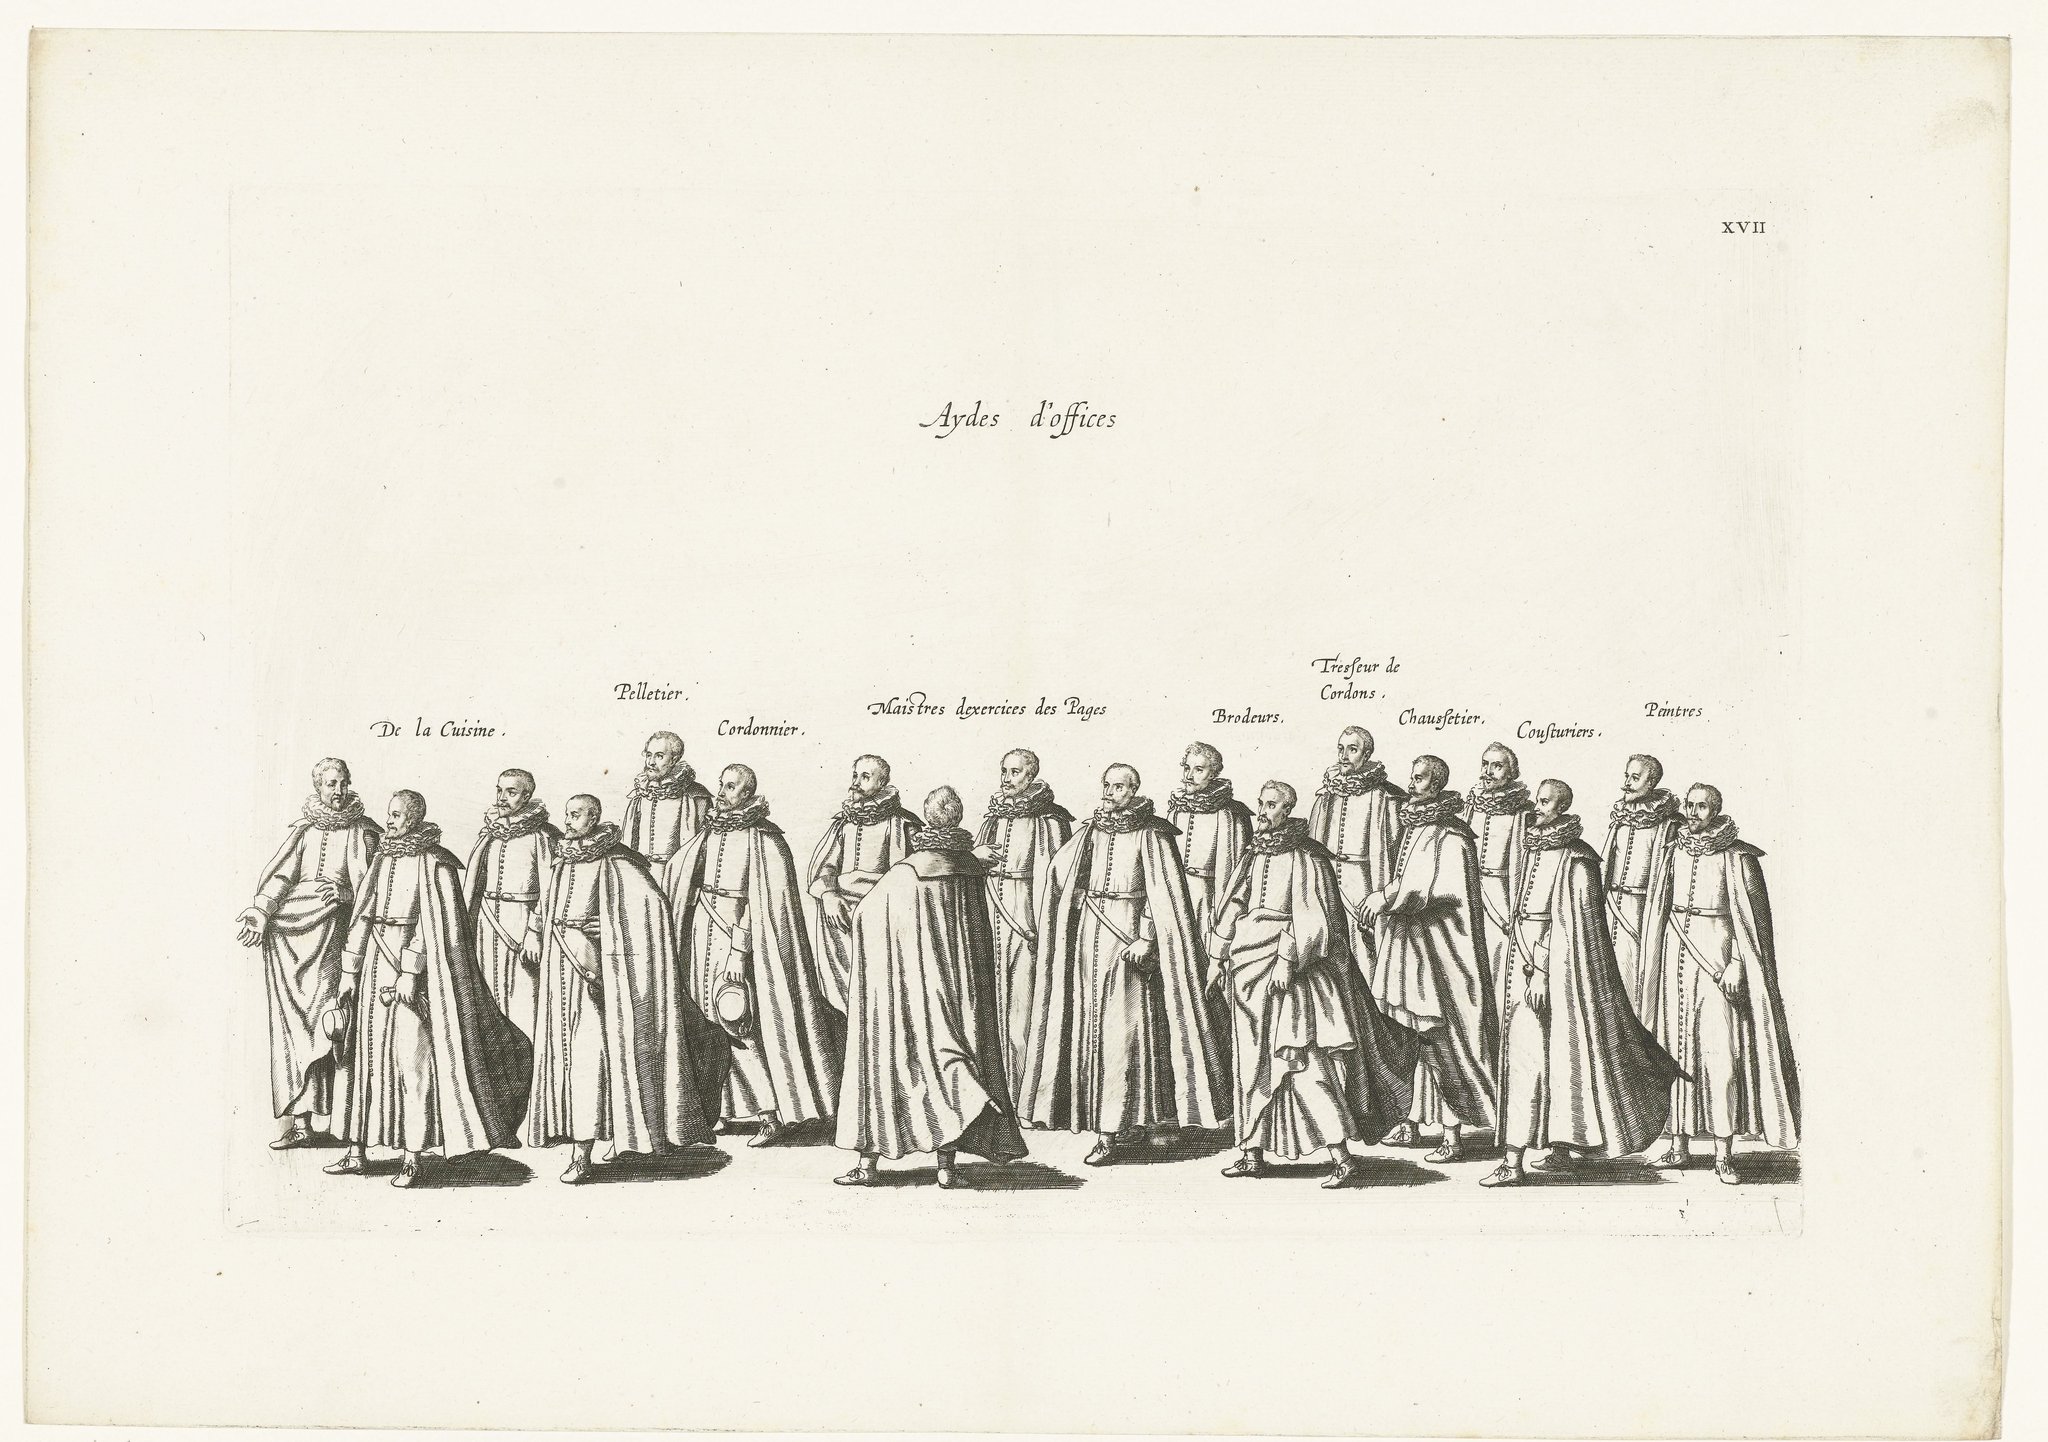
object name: print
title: Pompa funebris optimi potentissimiq. principis Alberti pii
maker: cornelis galle (i)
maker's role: print maker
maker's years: 1576-1650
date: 1623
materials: paper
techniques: etching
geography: southern netherlands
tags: brussels, albrecht aartshertog van oostenrijk, cortege, funeral procession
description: Deelnemers aan de begrafenisstoet. Plaat XVII in de serie van de begrafenis van aartshertog Albrecht van Oostenrijk te Brussel op 12 maart 1622.